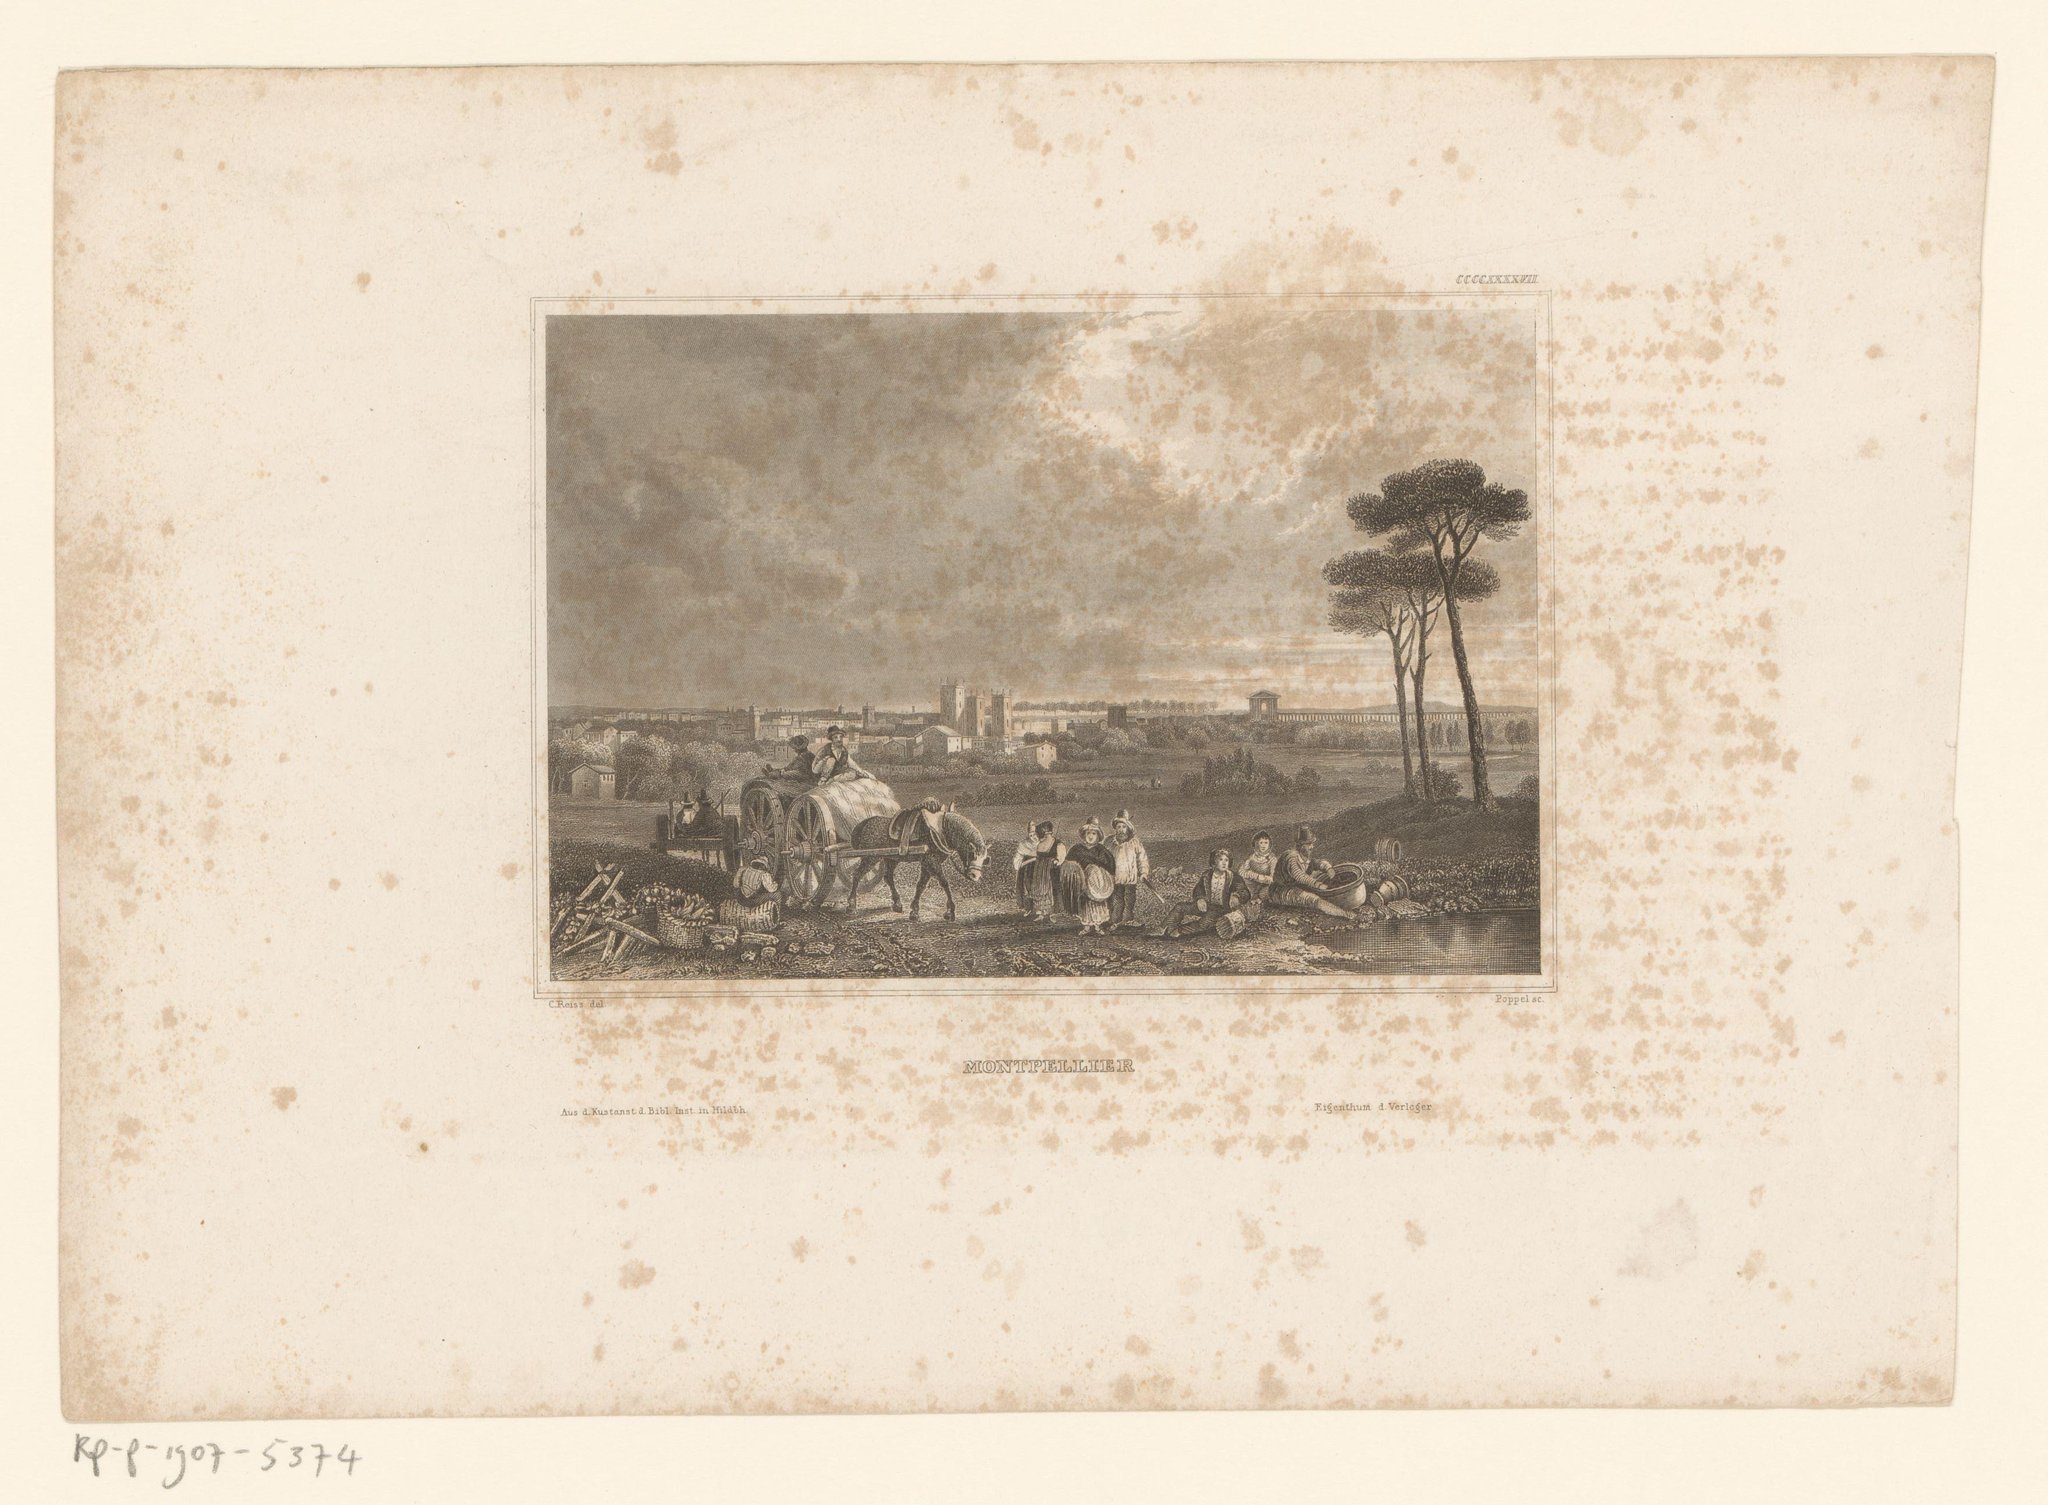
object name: book illustration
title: Montpellier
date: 1835-1863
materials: paper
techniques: engraving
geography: hildburghausen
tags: city-view, and landscape with man-made constructions, 'en route', traveller under way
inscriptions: collector's mark: Lugt 2228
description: Prent ook gebruikt in: Terwen, Johannes Leonardus. Het Koningrijk der Nederlanden voorgesteld in eene reeks van naar de natuur geteekende schilderachtige gezigten. Gouda: Van Goor, 1858-1862.